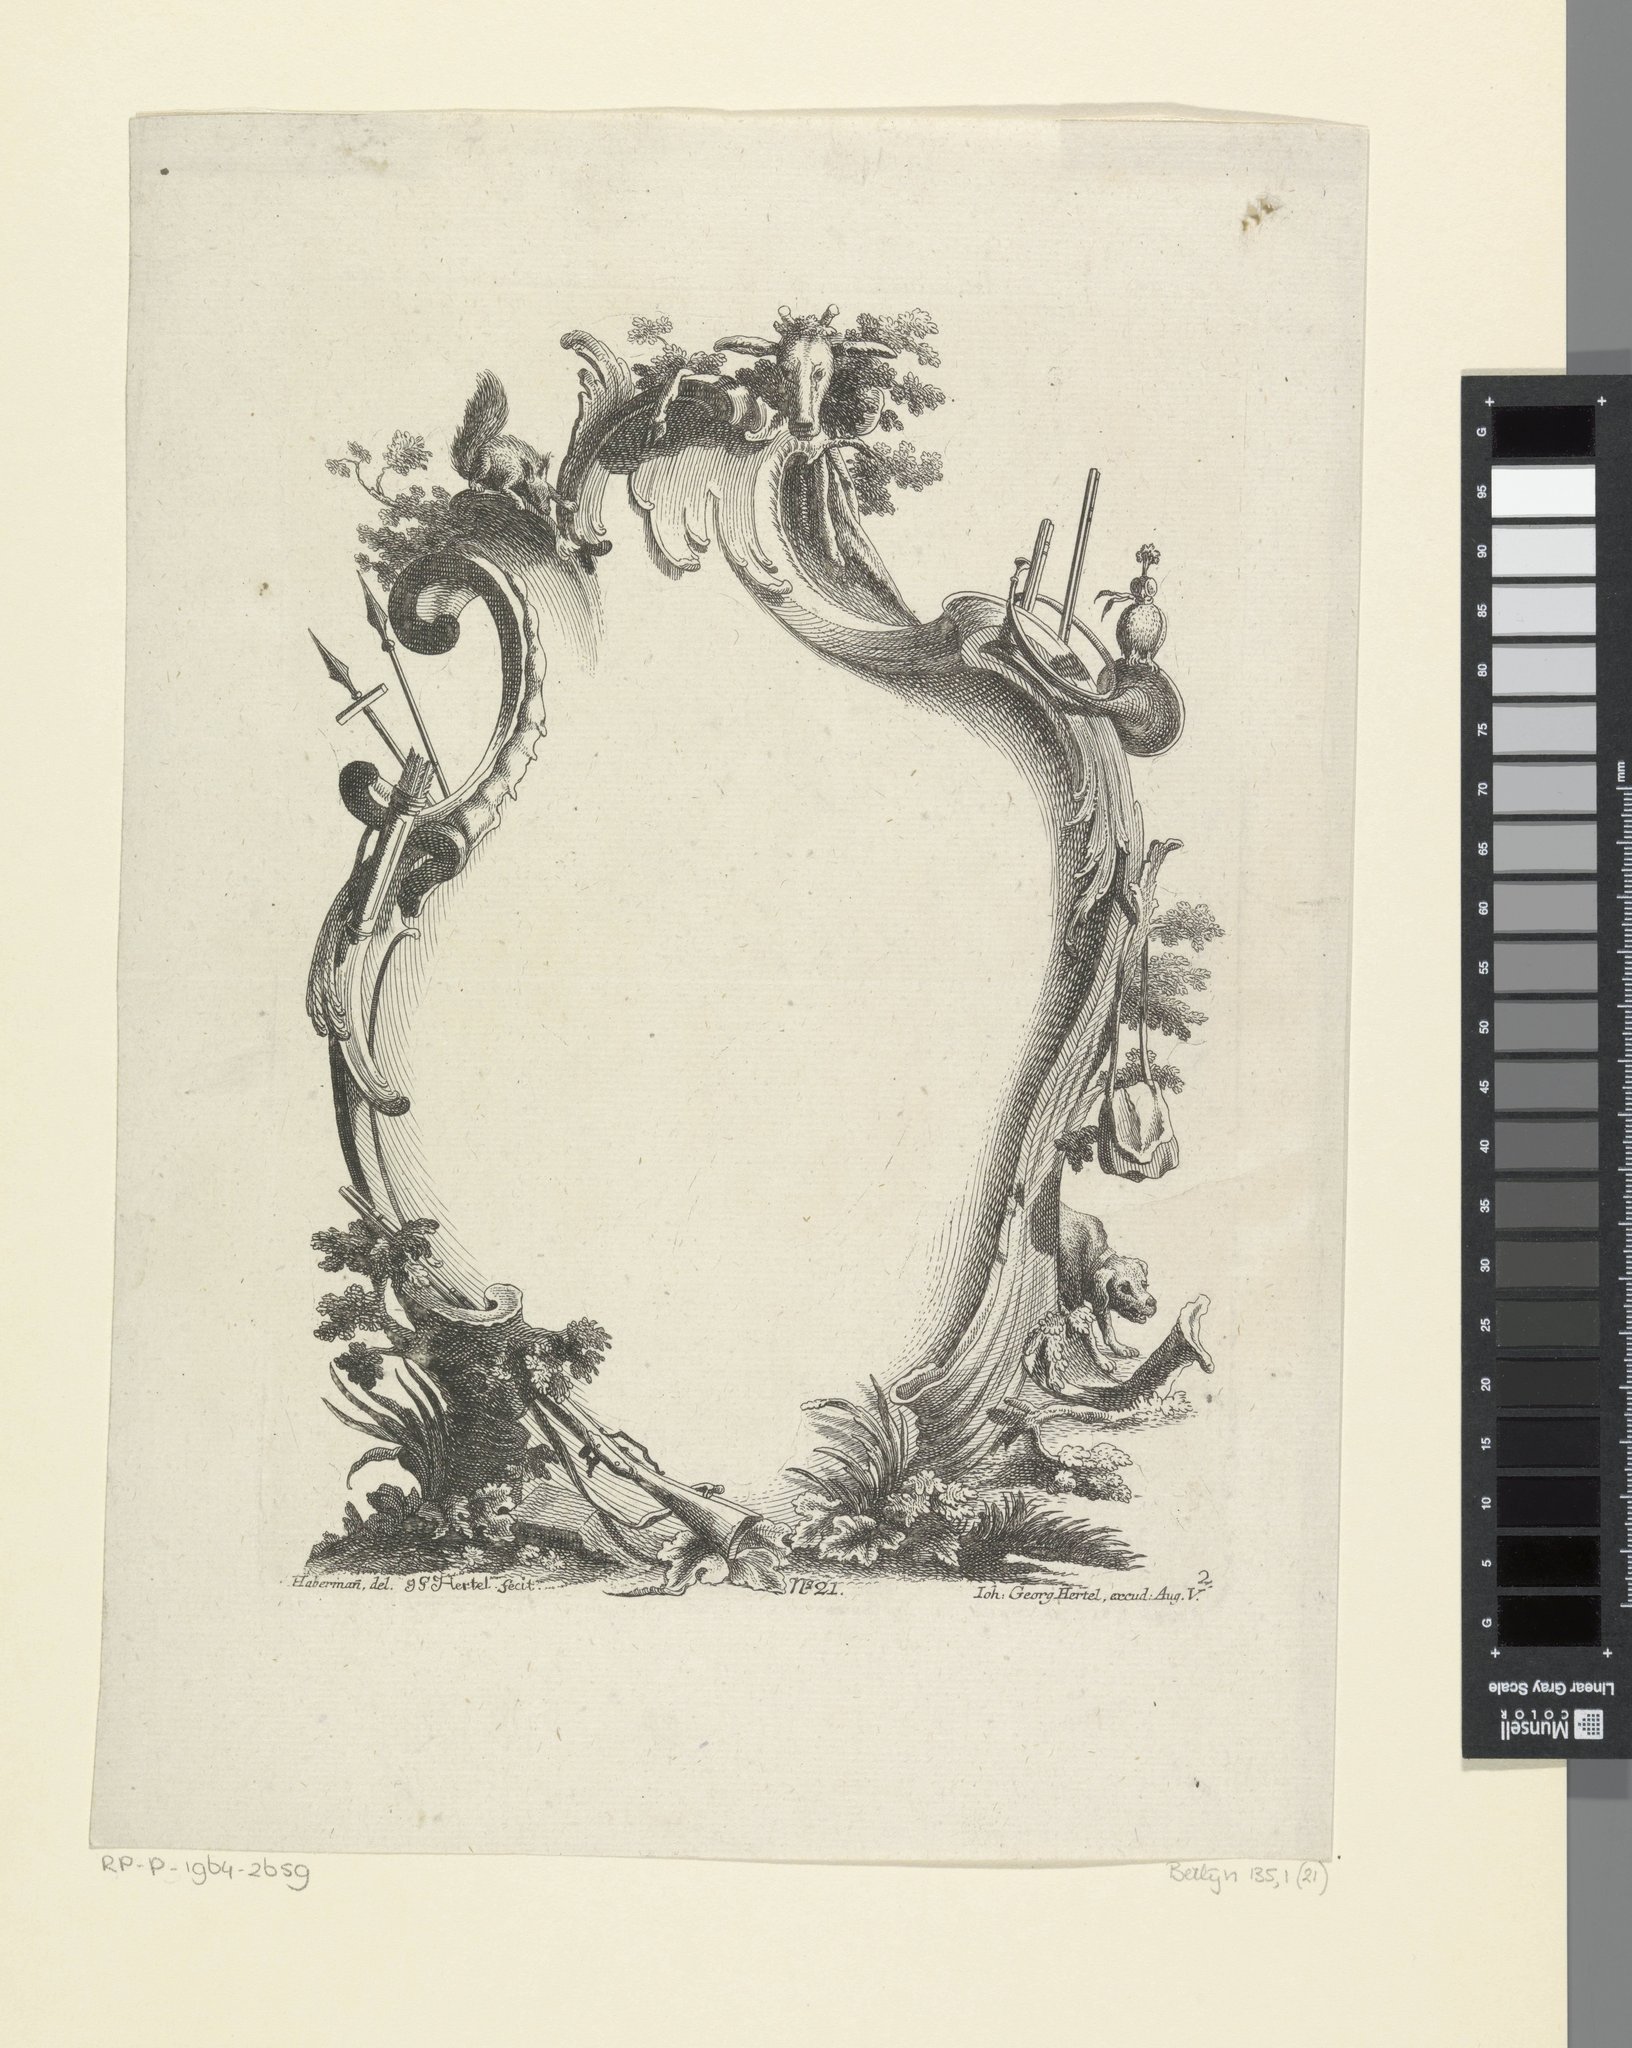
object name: print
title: Cartouche met jachtgerelateerde objecten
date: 1731-1775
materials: paper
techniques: etching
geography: augsburg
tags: hunting, chase, ornament ~ cartouche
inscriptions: collector's mark: Lugt 2228, collector's mark: Lugt 2760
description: Rocaille cartouche met objecten die te maken hebben met de jacht, zoals een geweer, lansen, dieren, jachthoorn, valk en een hond. Uitgeversnummer 21.